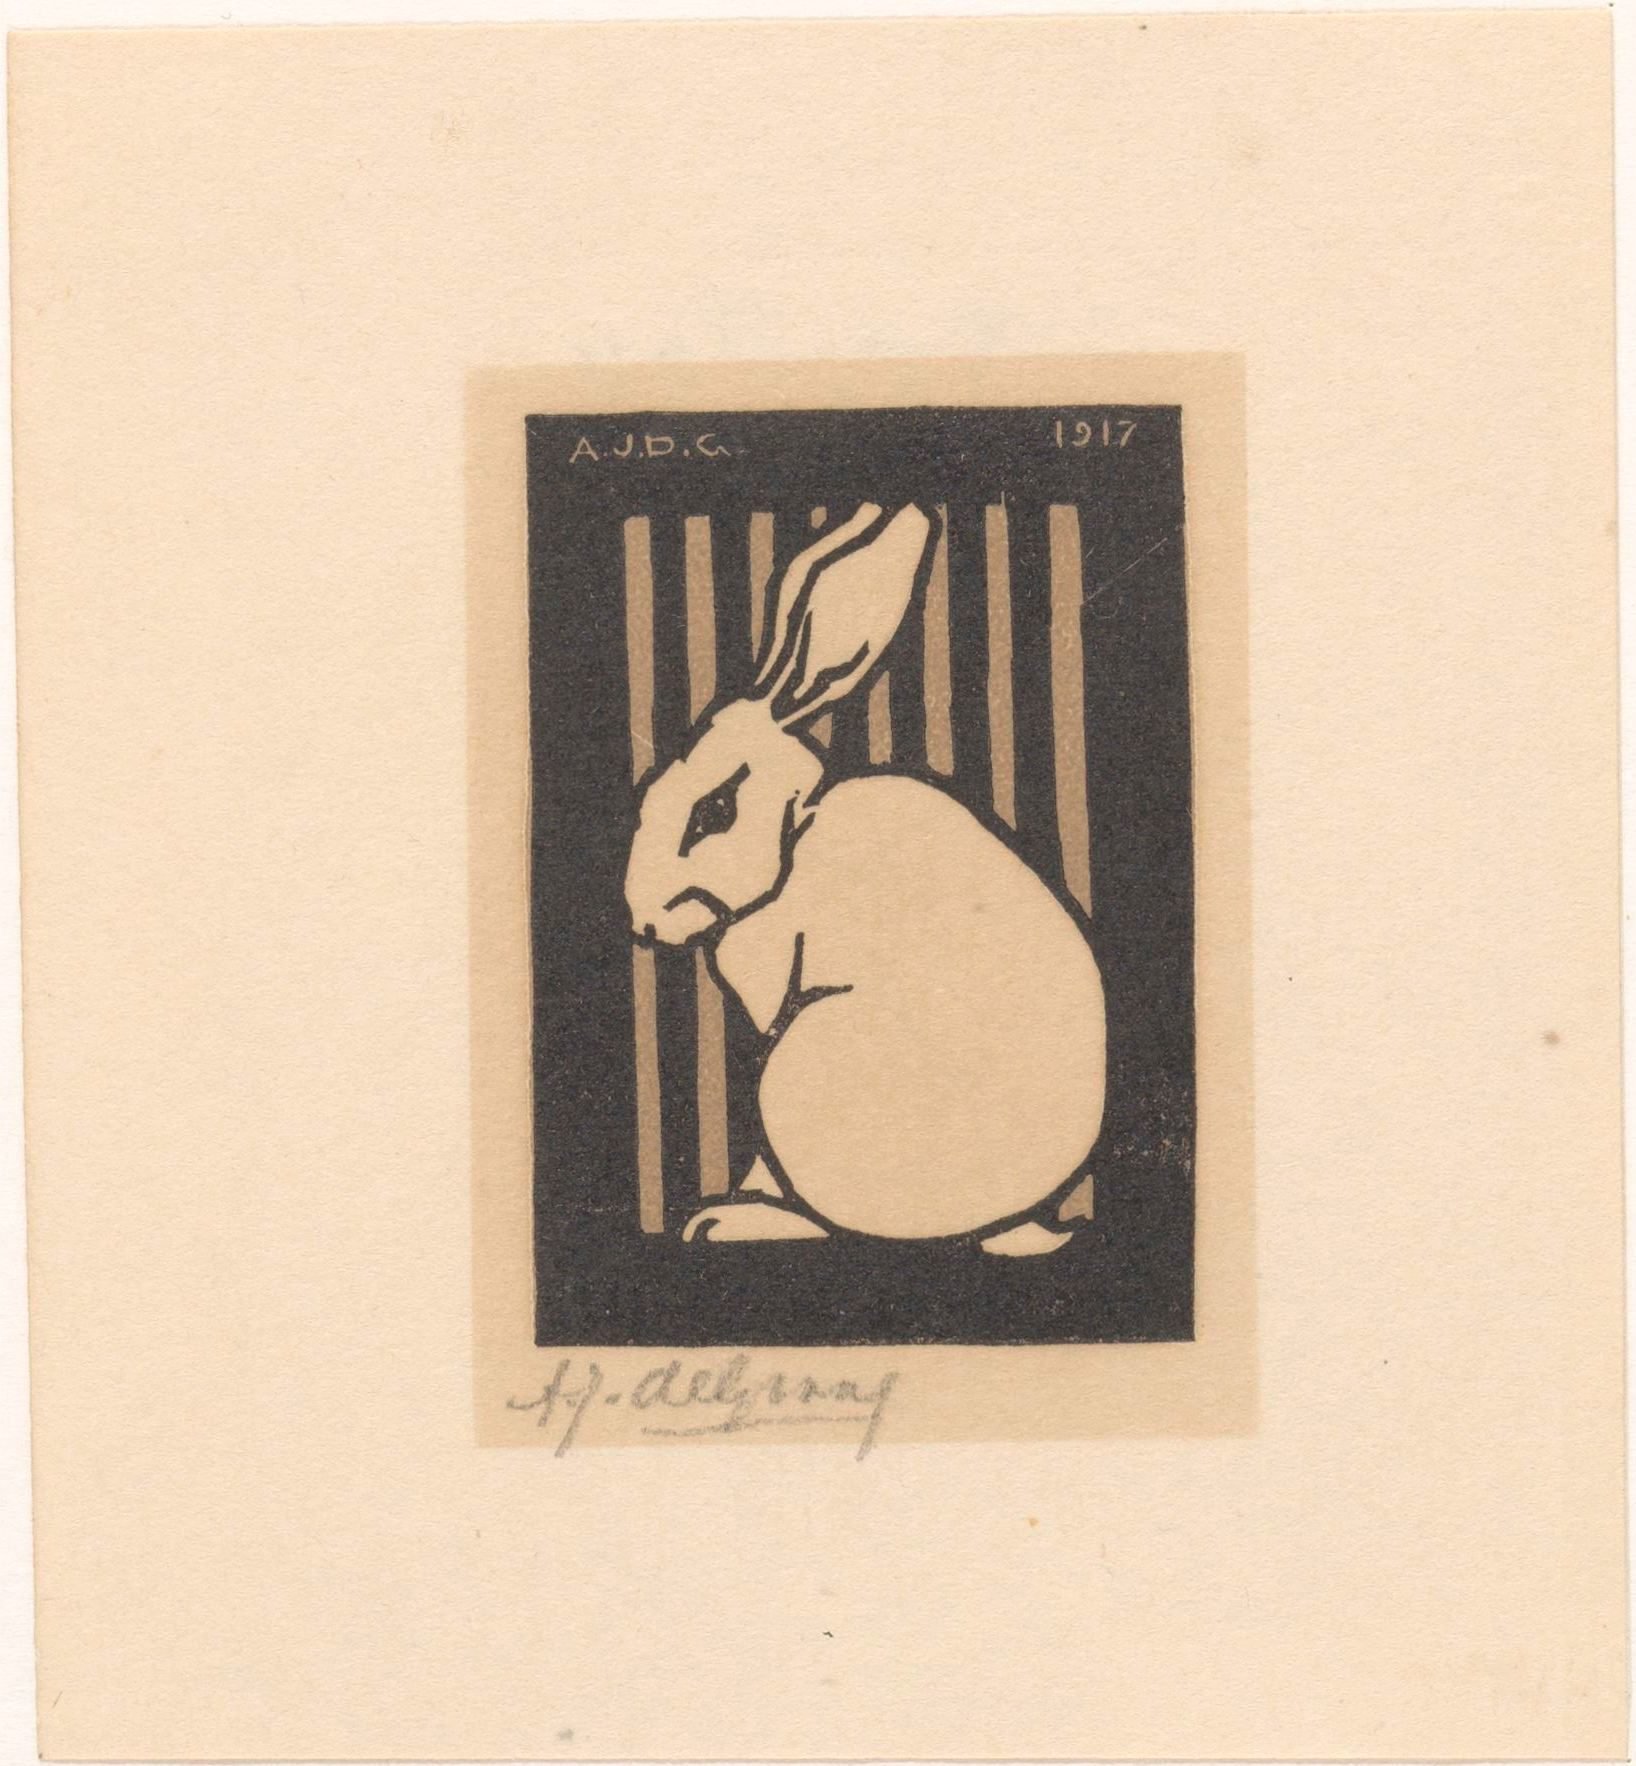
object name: print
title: Zittend konijn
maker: julie de graag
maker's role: draughtsman, print maker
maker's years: 1877-1924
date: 1917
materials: paper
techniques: woodcut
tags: rodents: rabbit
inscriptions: collector's mark: Lugt 2228